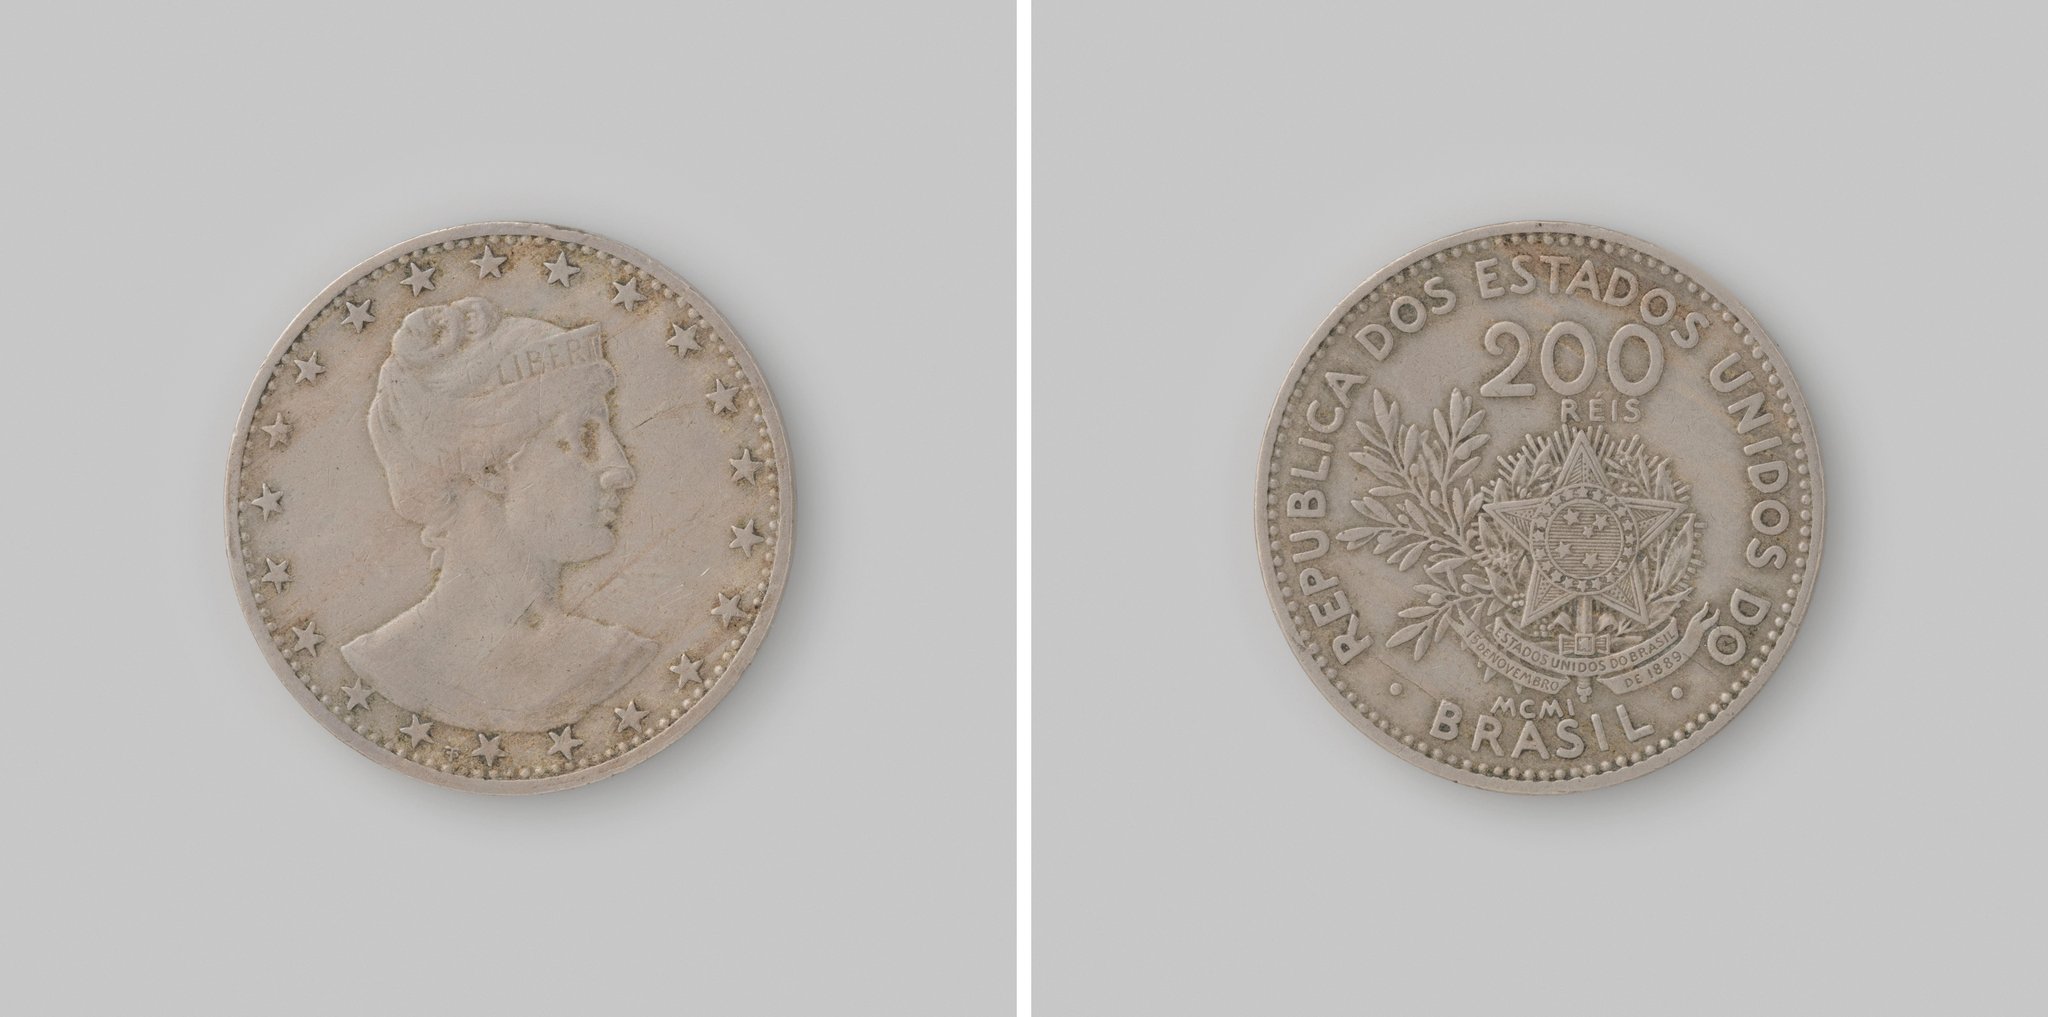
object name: coin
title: 200 reis van Brazilië, 1901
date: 1901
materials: nickel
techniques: striking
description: Koper-nikkelen munt. Voorzijde: bninen een ring van sterren borstbeeld van een vrouw met vrijheidshoed naar rechts. Keerzijde: op een tak van bladeren een op een krans van twee takken aangebrachte ster, waaronder banderol met opschrift. Daaronder jaartal: MCMI. Boven ster in twee regels waarde-aanduiding: 200 réis. Gladde rand.